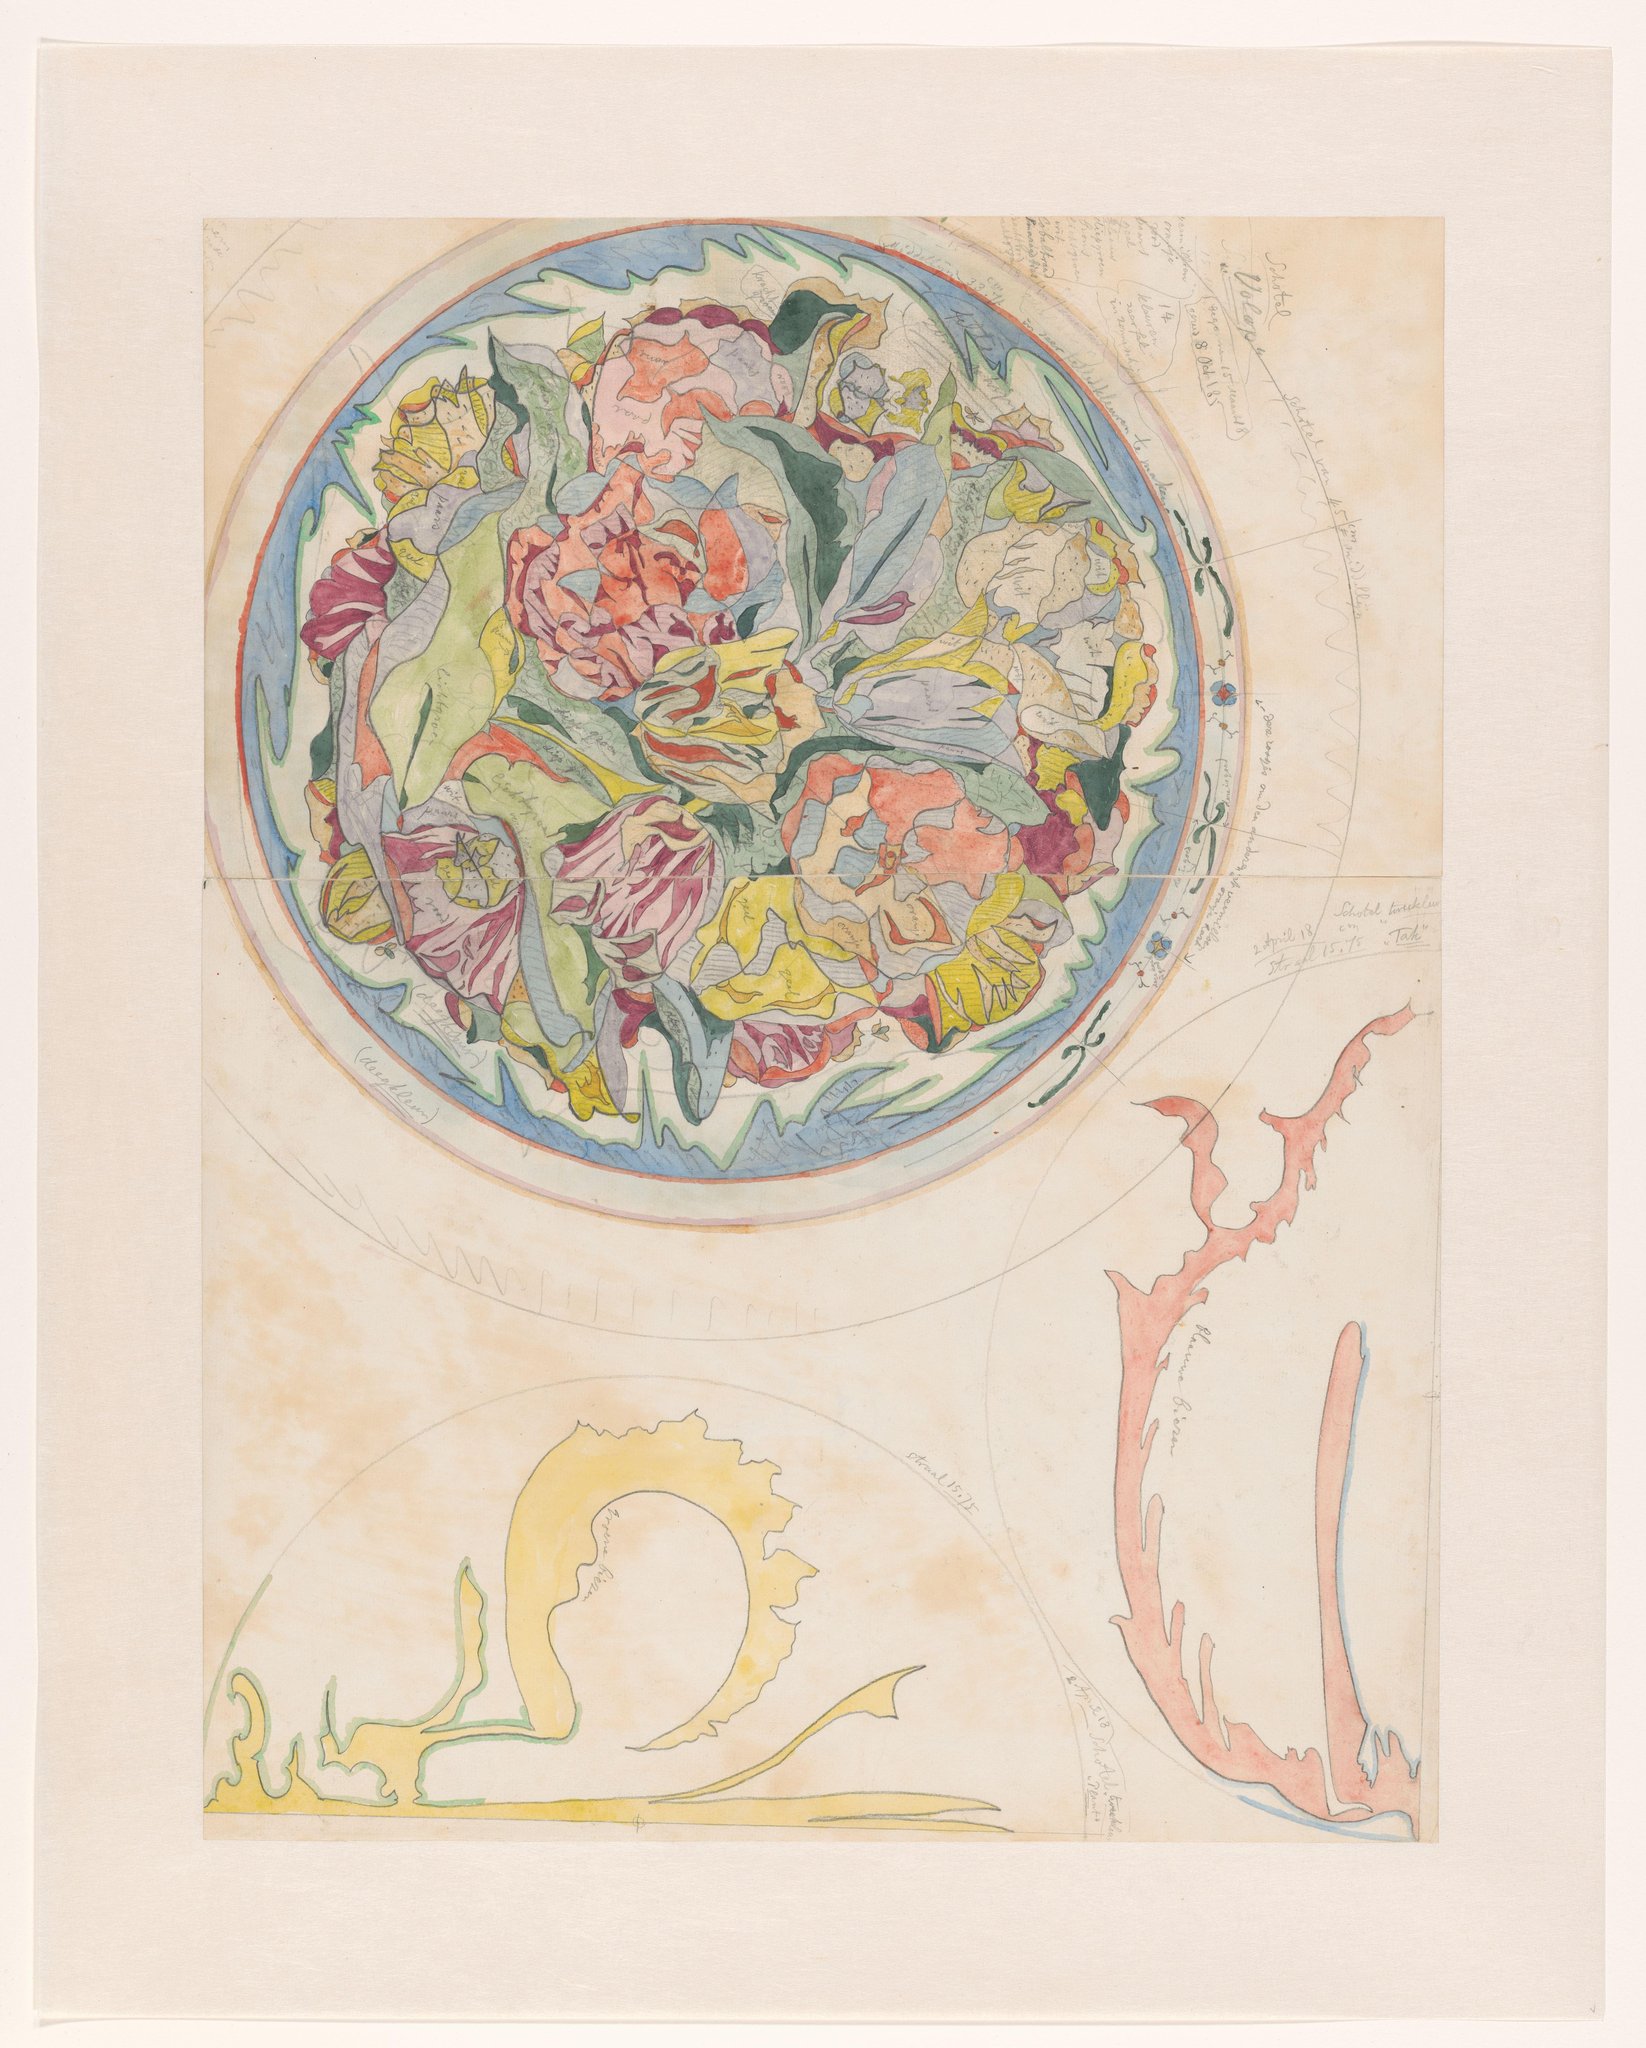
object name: watercolor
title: Volop / Plant / Tak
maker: theo colenbrander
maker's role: draughtsman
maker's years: 1841-1930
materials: paper, pencil, watercolor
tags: (other) historical names, flowers: tulip, ornament derived from plant forms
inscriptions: date: ‘begonnen 15 maart 18 / gereed 8 oct 18’